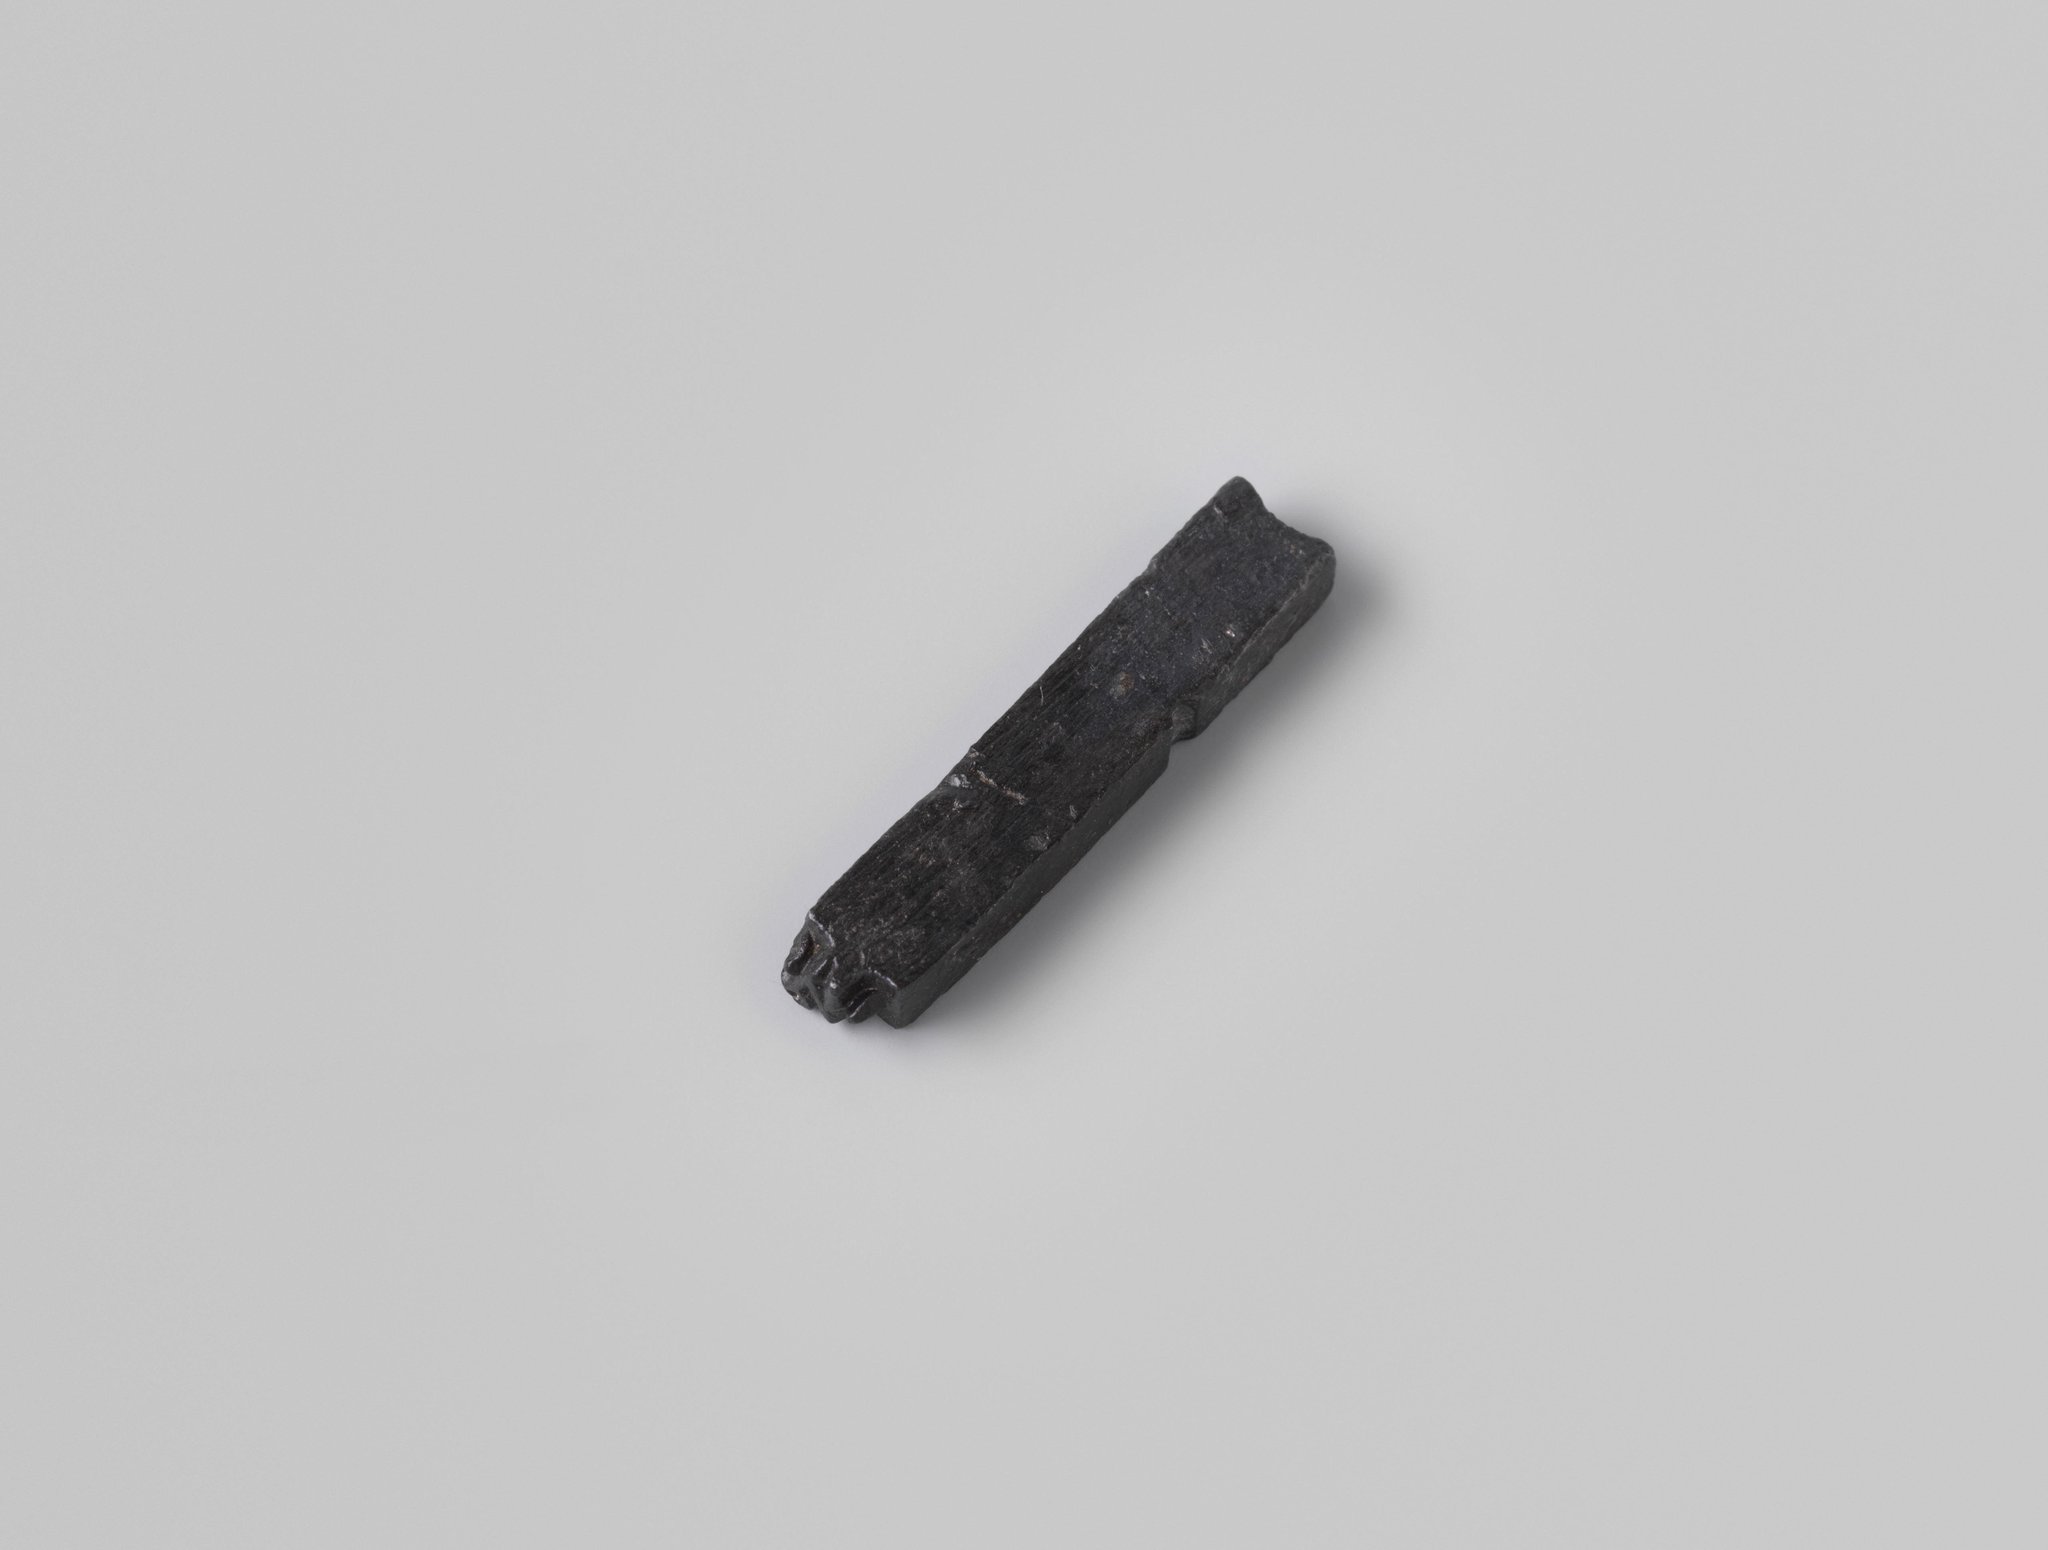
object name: type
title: Printing type with a Malay character from the wreck of the Dutch East India ship Hollandia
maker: Anonymous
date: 1700-1743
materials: lead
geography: netherlands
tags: verenigde oostindische compagnie, hollandia (schip), annet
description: Printing type, rectangular, groove in one side, (Malay?) character.